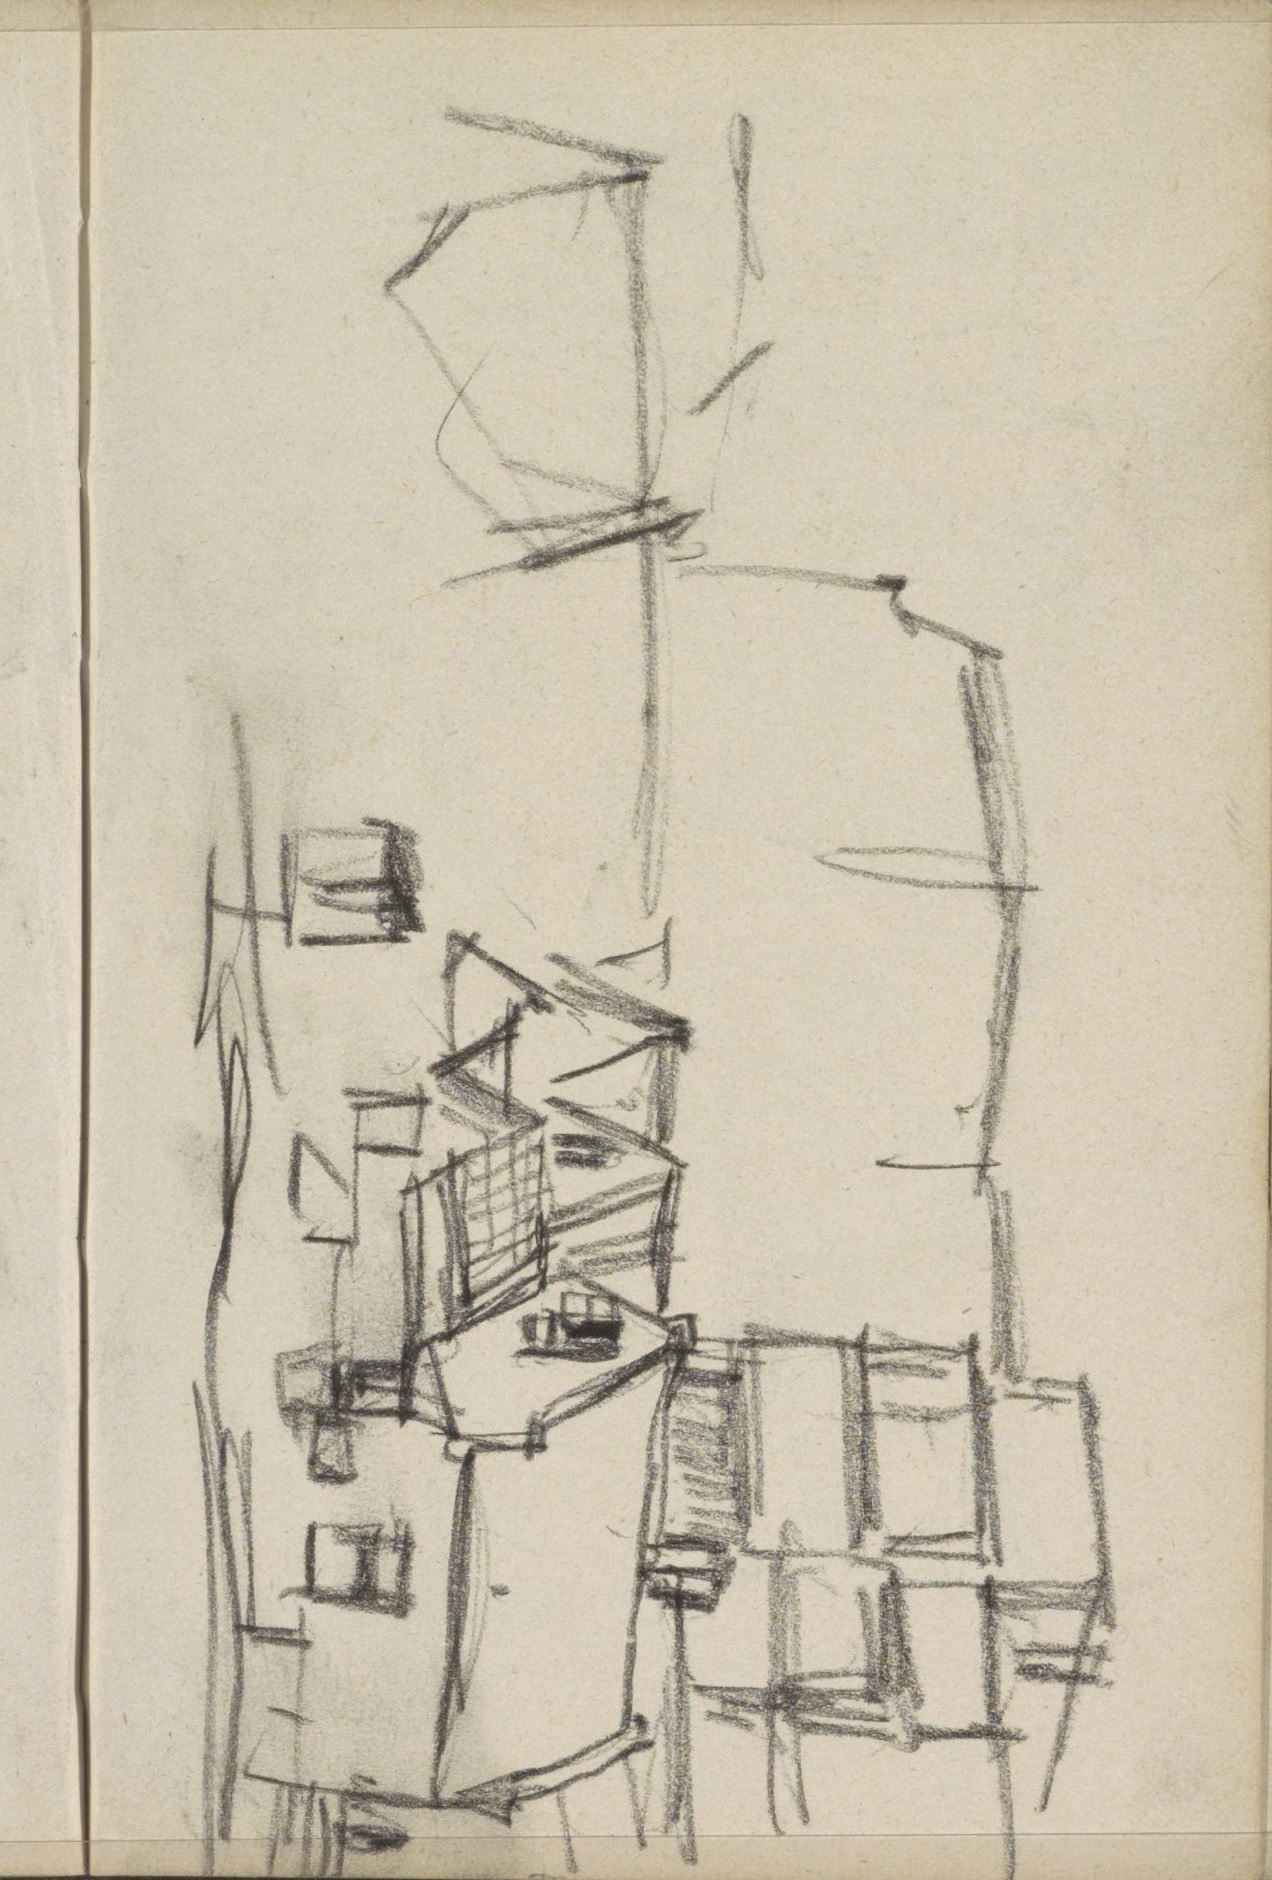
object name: sketchbook leaf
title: Bebouwing, mogelijk in de Rustenburgerstraat te Amsterdam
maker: george hendrik breitner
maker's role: draughtsman, painter, print maker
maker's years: 1857-1923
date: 1900-1923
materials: chalk, paper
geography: amsterdam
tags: civic architecture; edifices; dwellings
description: Pagina 54 uit een schetsboek met 39 bladen.